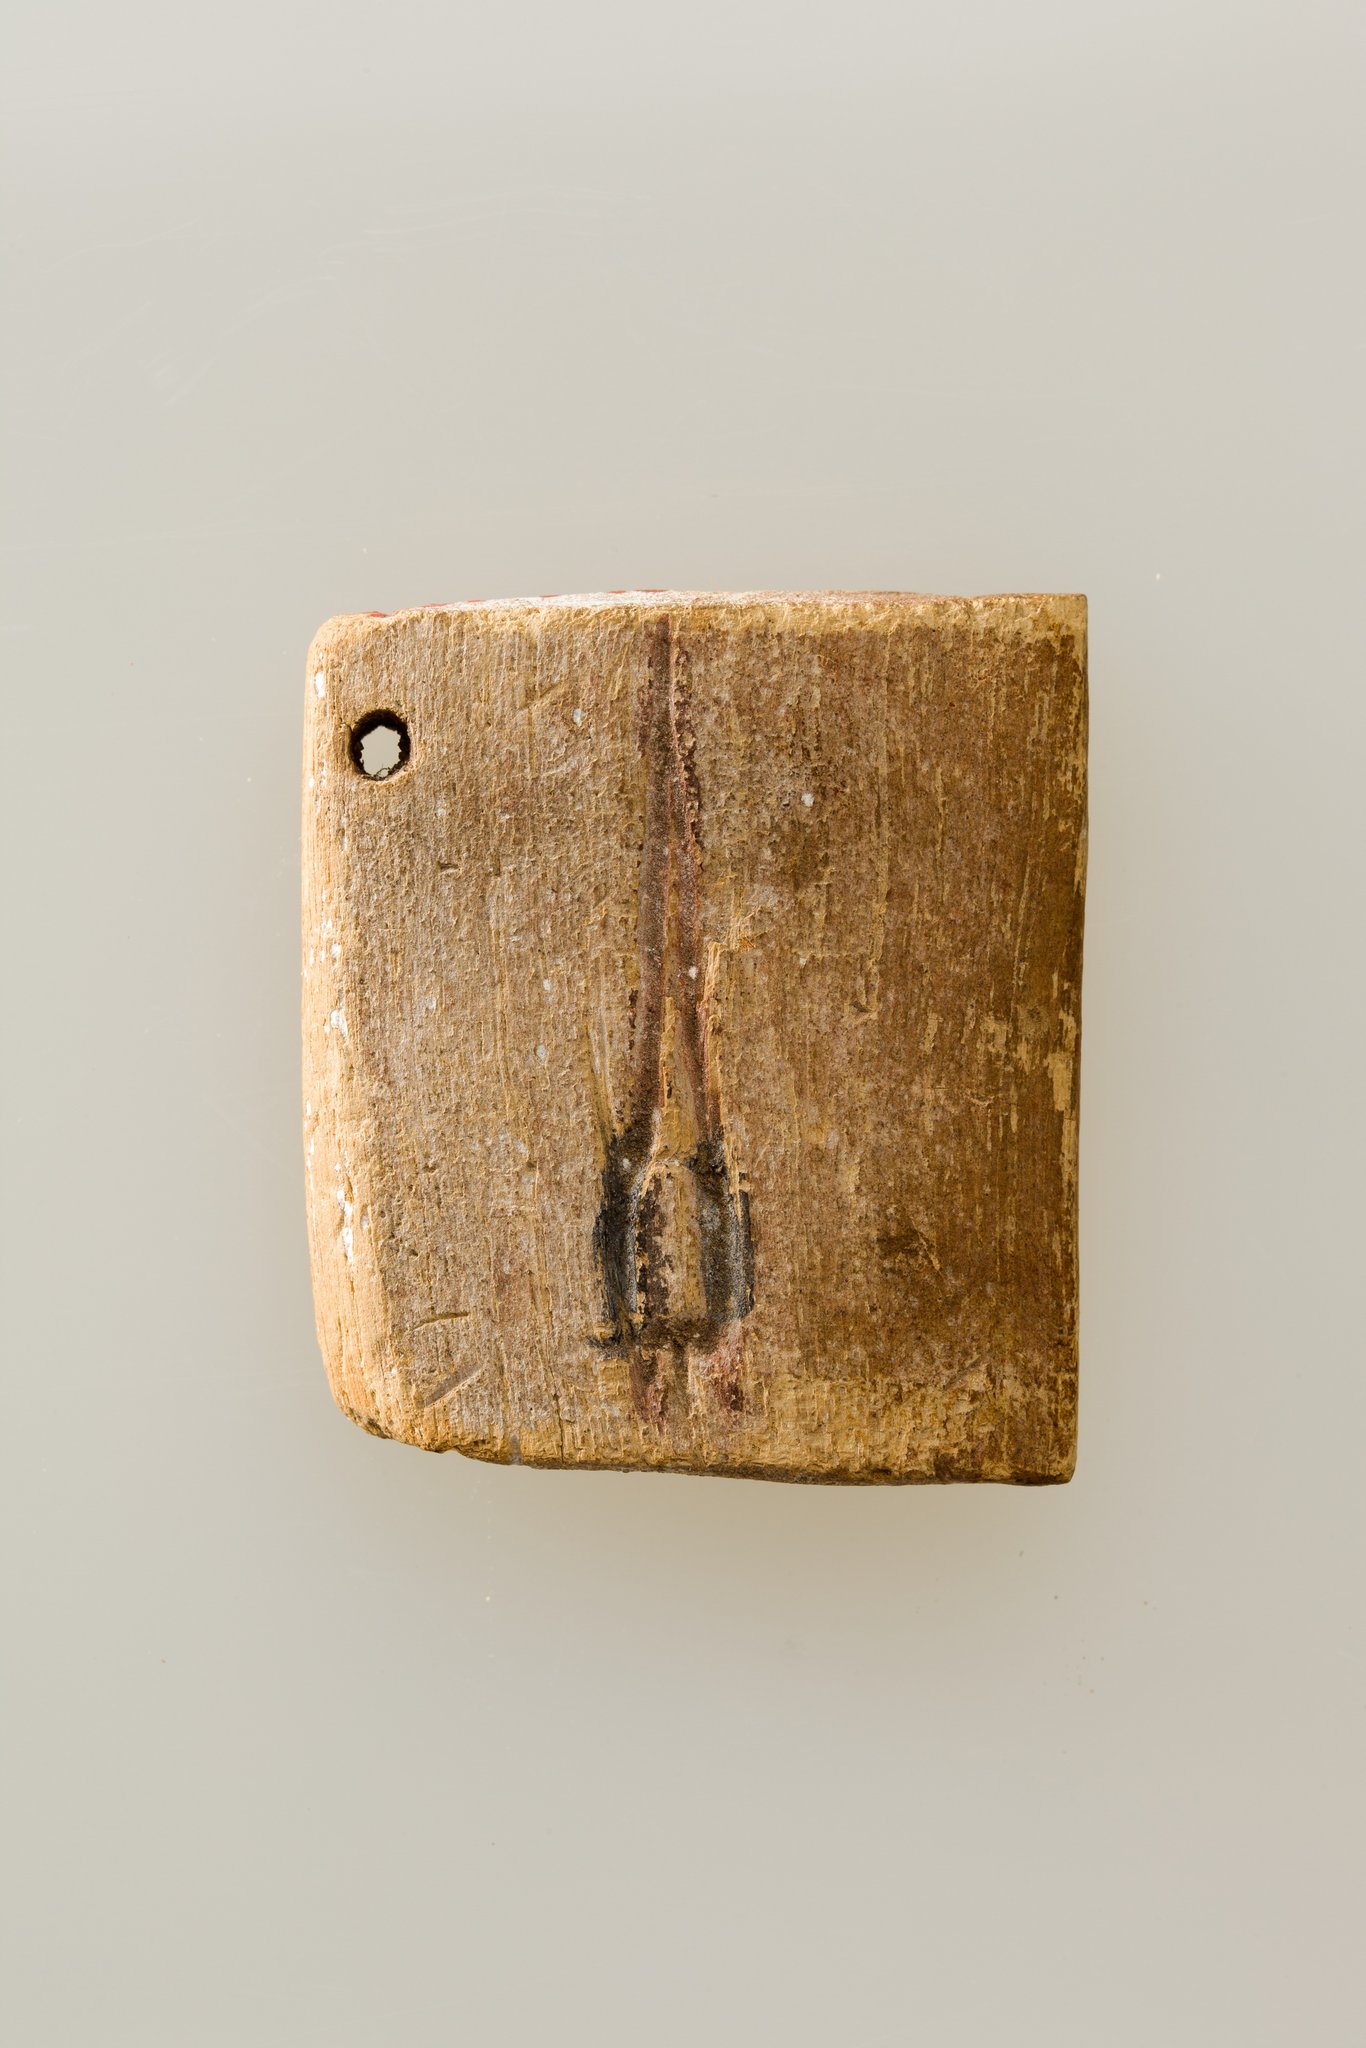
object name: label, bundle of arrow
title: Ivory label incised with an early hieroglyph that may be the image of a bundle of arrows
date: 2650 BCE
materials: ink, wood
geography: egypt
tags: hieroglyphs